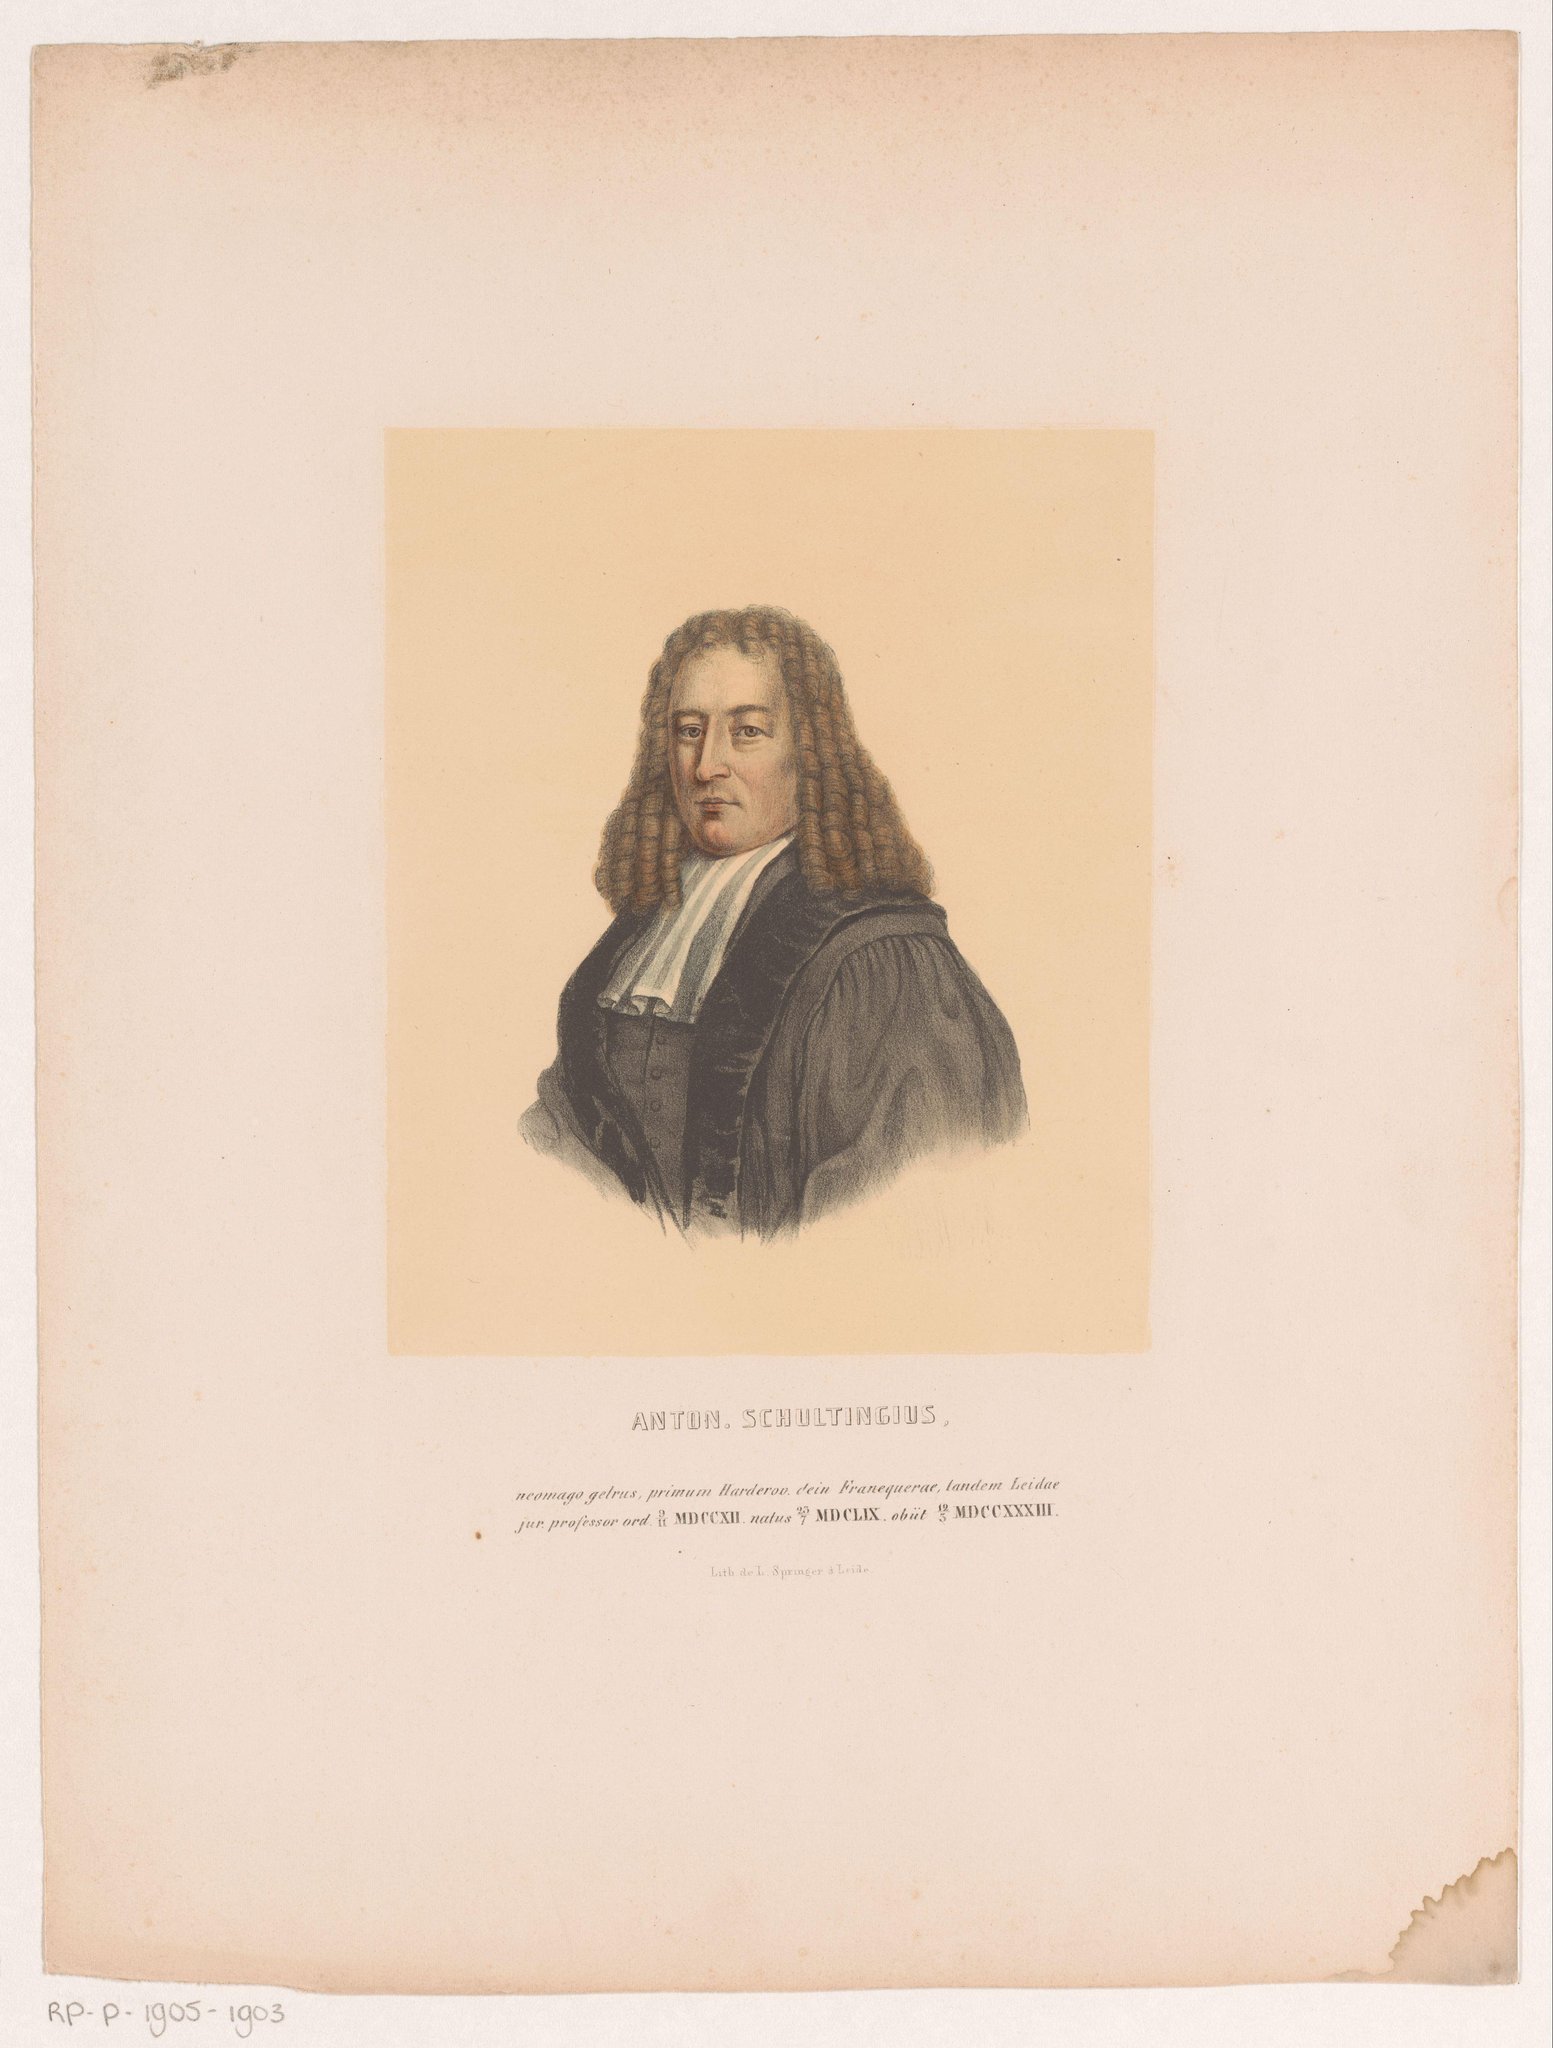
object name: print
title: Portret van Antonius Schultingh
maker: leendert springer (i)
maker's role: draughtsman, painter, print maker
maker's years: 1789-1871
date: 1850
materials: paper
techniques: lithograph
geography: leiden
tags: leiden, historical persons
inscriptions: collector's mark: Lugt 2228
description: Prent uit: Springer, Leendert. Galerij van hoogleeraren aan de Hoogeschool te Leijden, naar de oorspronkelijke afbeeldsels op de Senaat-zaal aldaar berustende. Leiden: Springer, Leendert., s.a. [circa 1850].